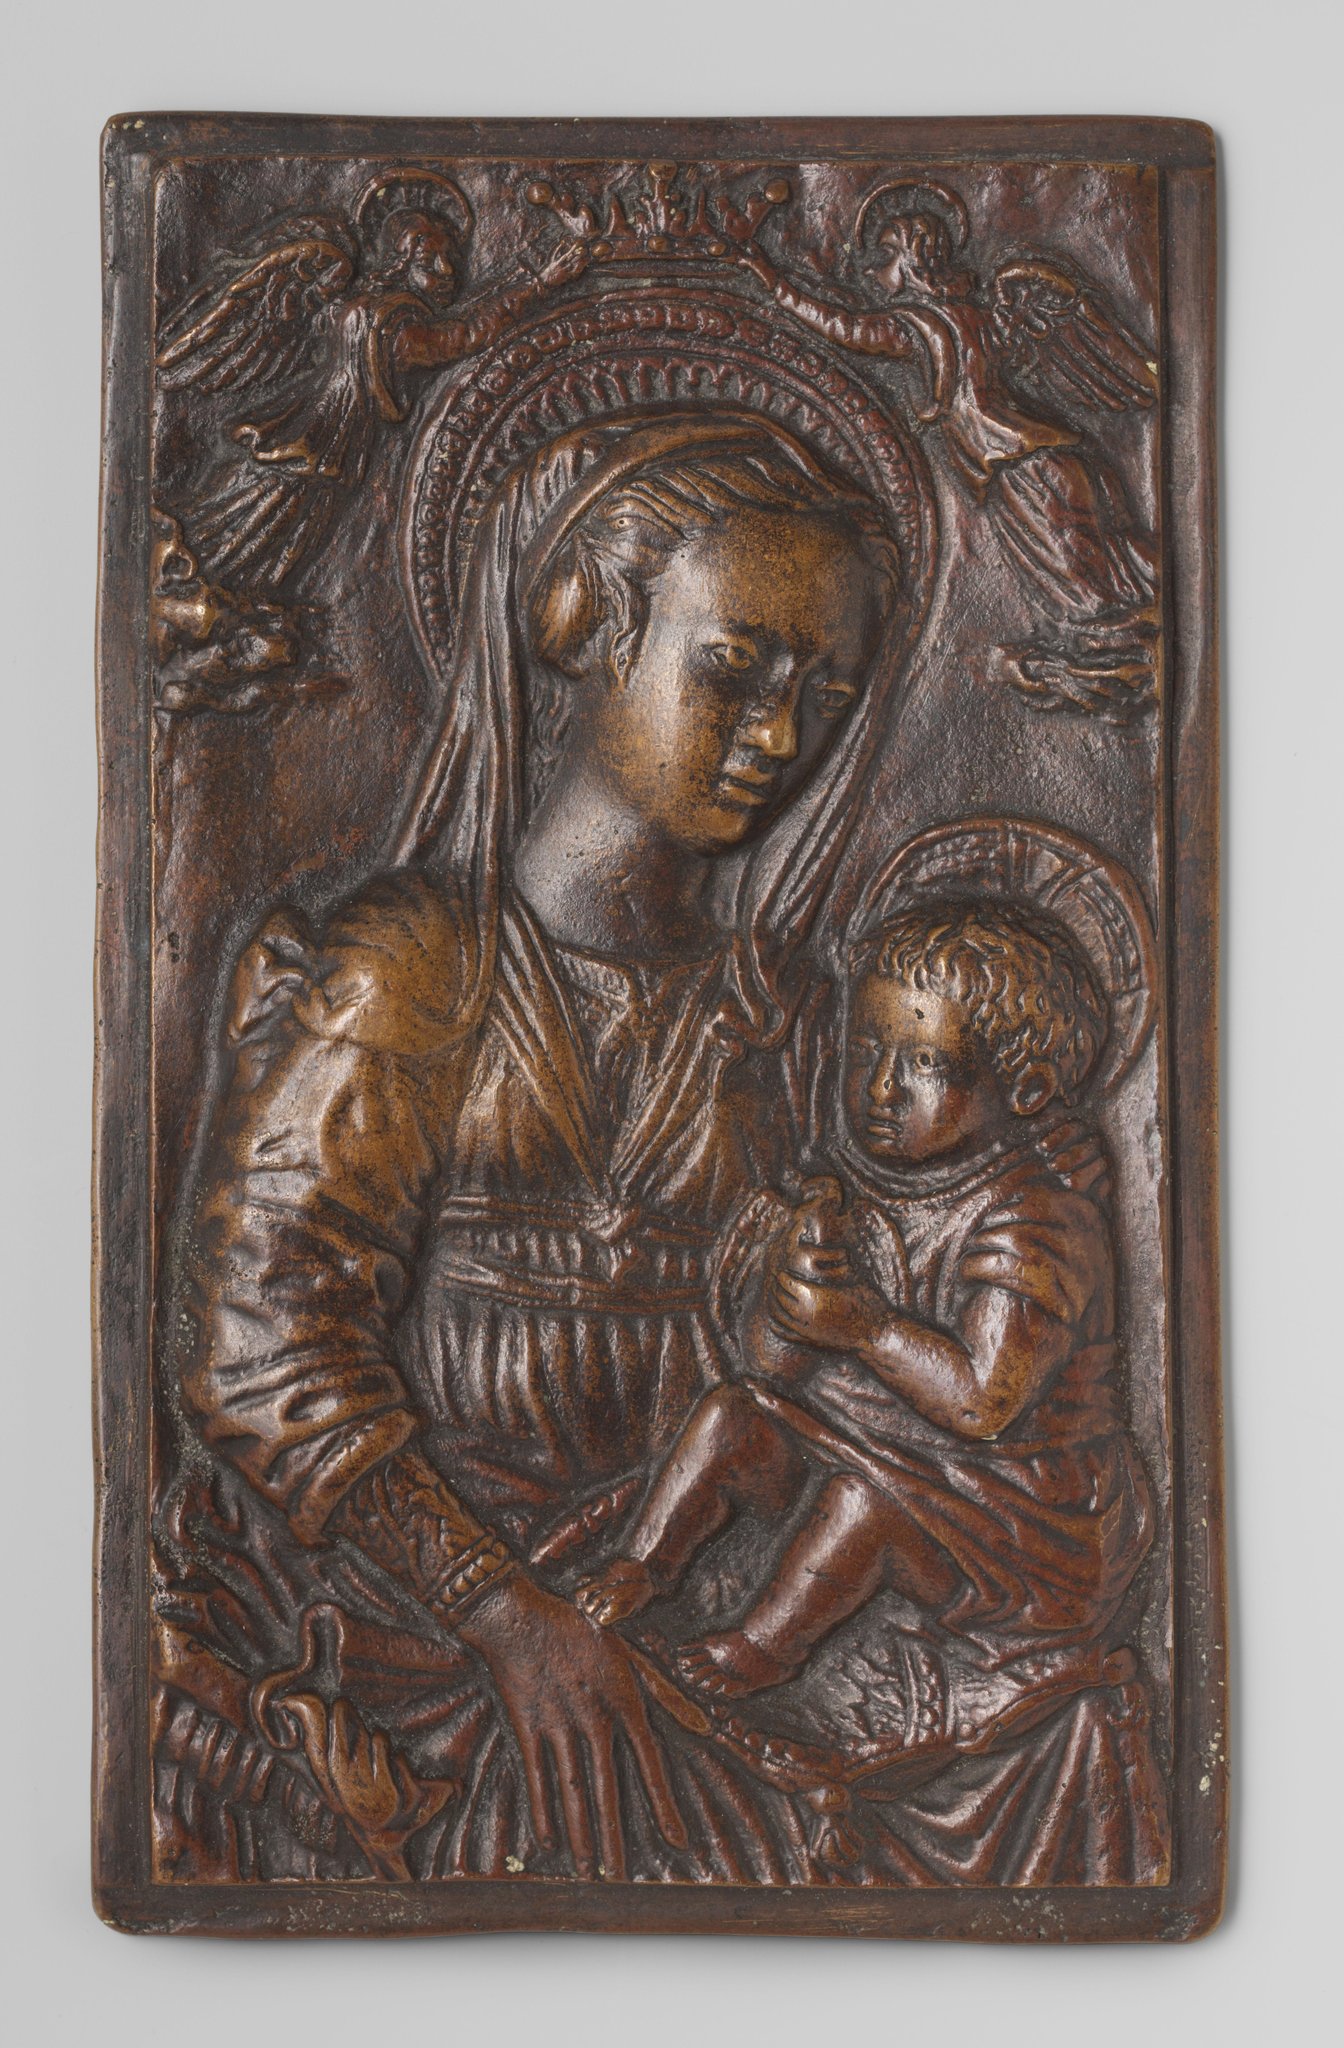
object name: plaque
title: Madonna met kind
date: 1600-1699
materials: bronze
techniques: casting, patinaed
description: Rechthoekige, staande plaquette met rondom getrapte rand om het stuk te kunnen inlijsten of monteren. De op een troon zittende, halflange Maria met het Christuskind op schoot heeft een aureool om haar hoofd en twee zwevende engelen houden een kroon boven haar.